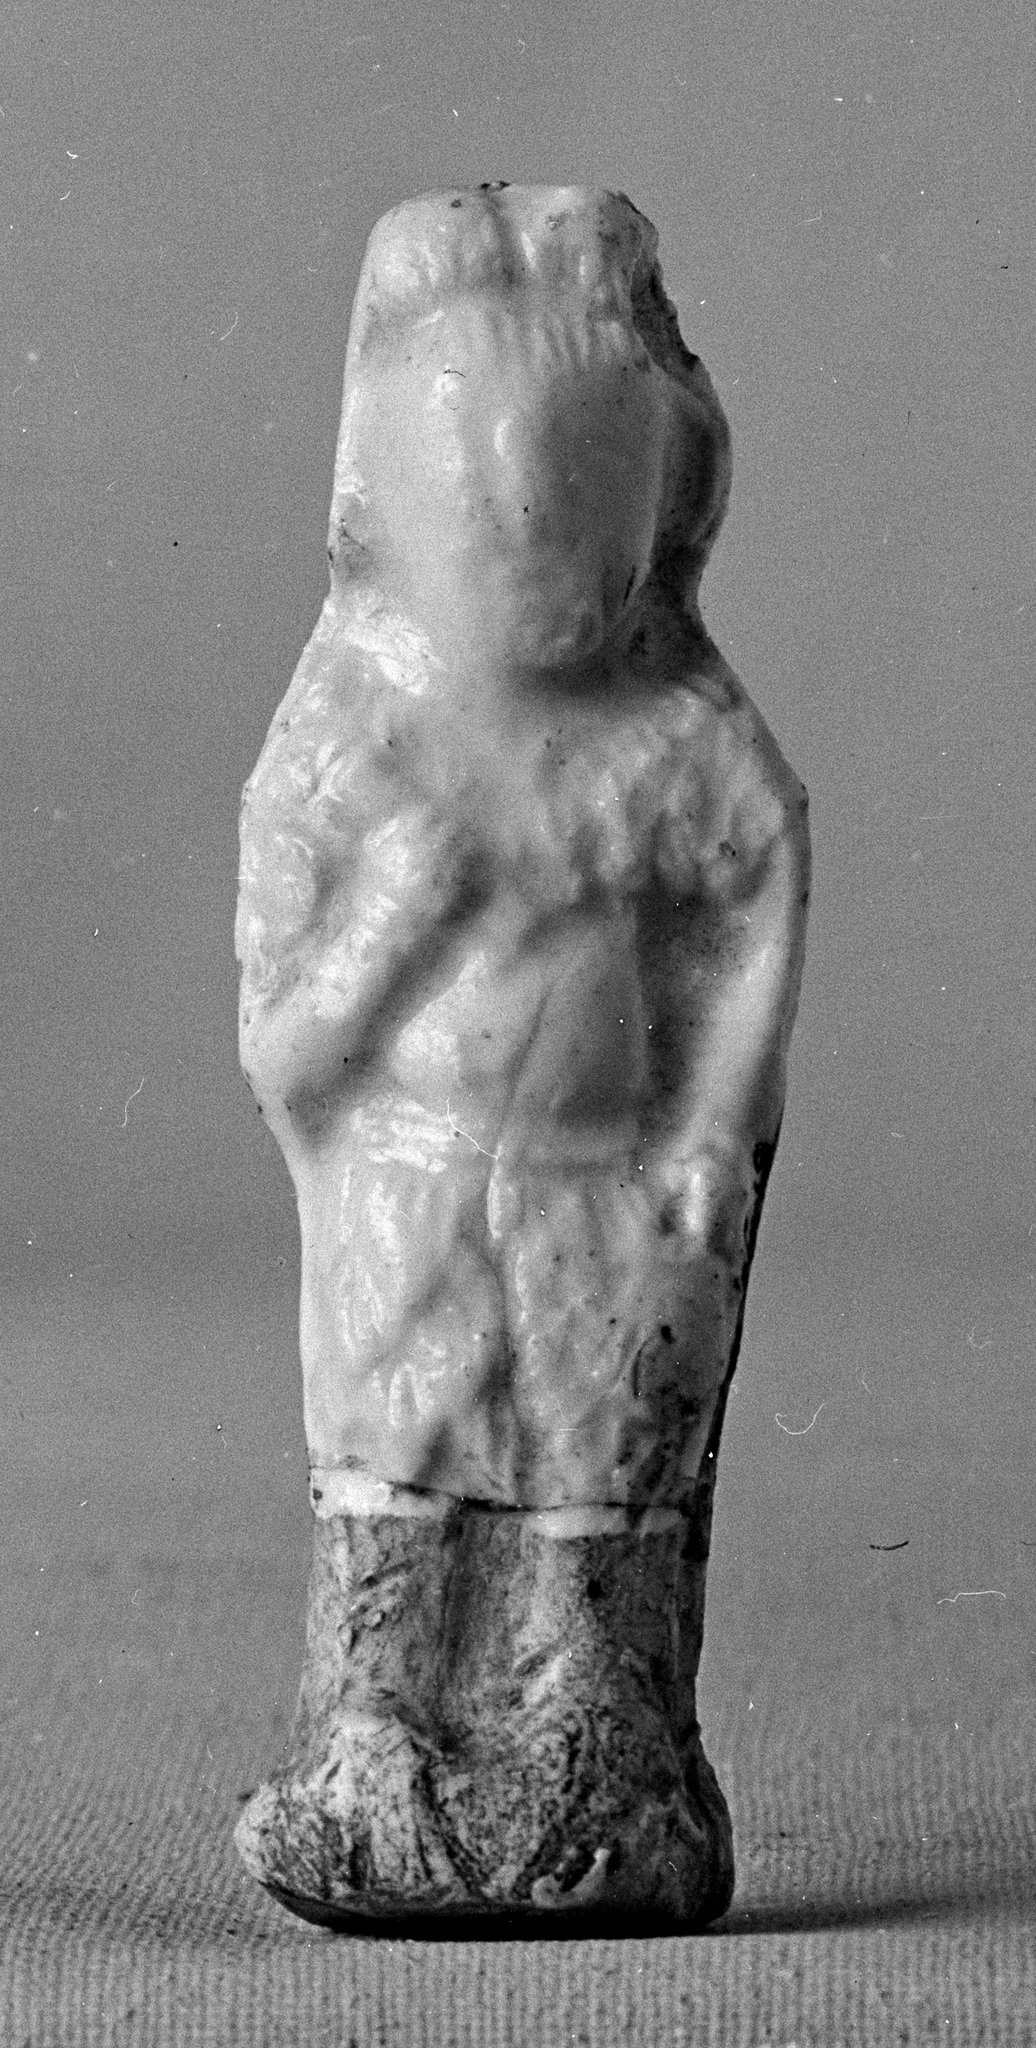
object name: figure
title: Minature standing figure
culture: chinese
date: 1001-1200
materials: glaze, stoneware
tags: human figures